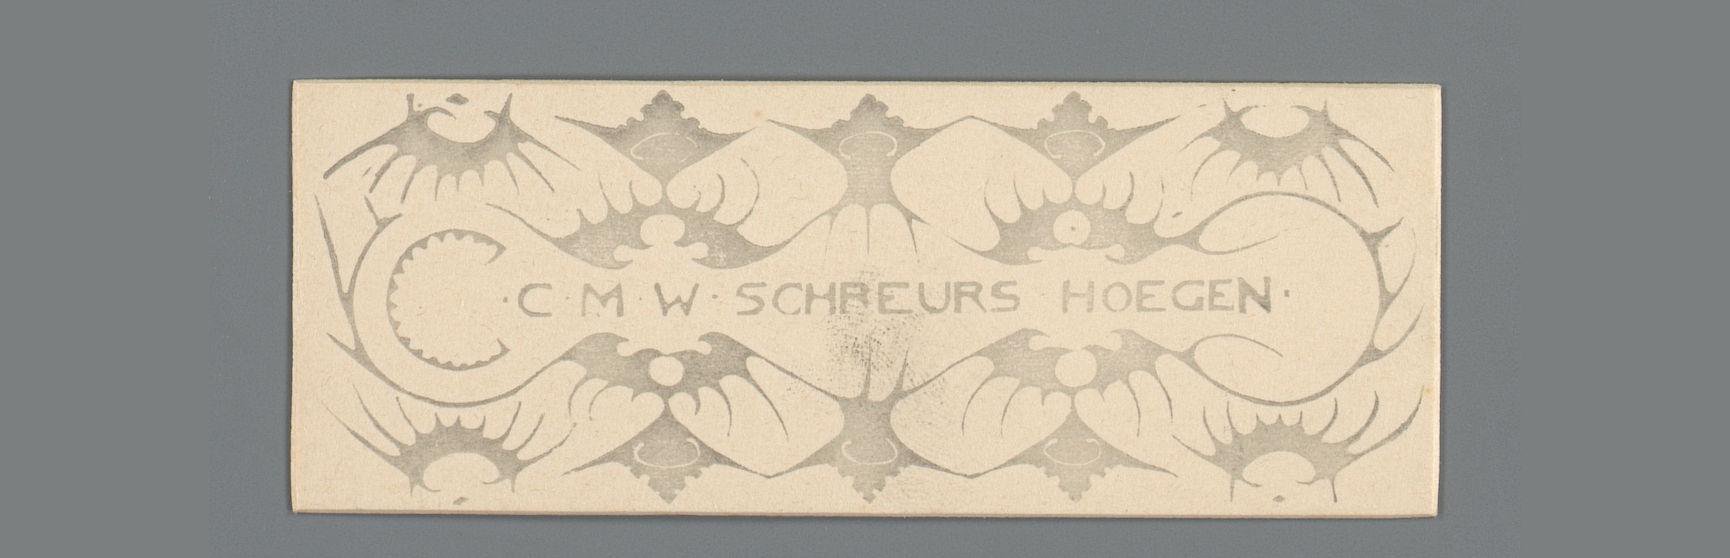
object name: print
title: Visitekaart van C.M.W. Schreurs-Hoegen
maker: mathieu lauweriks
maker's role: designer, draughtsman, print maker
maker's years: 1864-1932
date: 1896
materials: paper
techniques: woodcut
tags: ornaments ~ art, visiting-card, calling-card